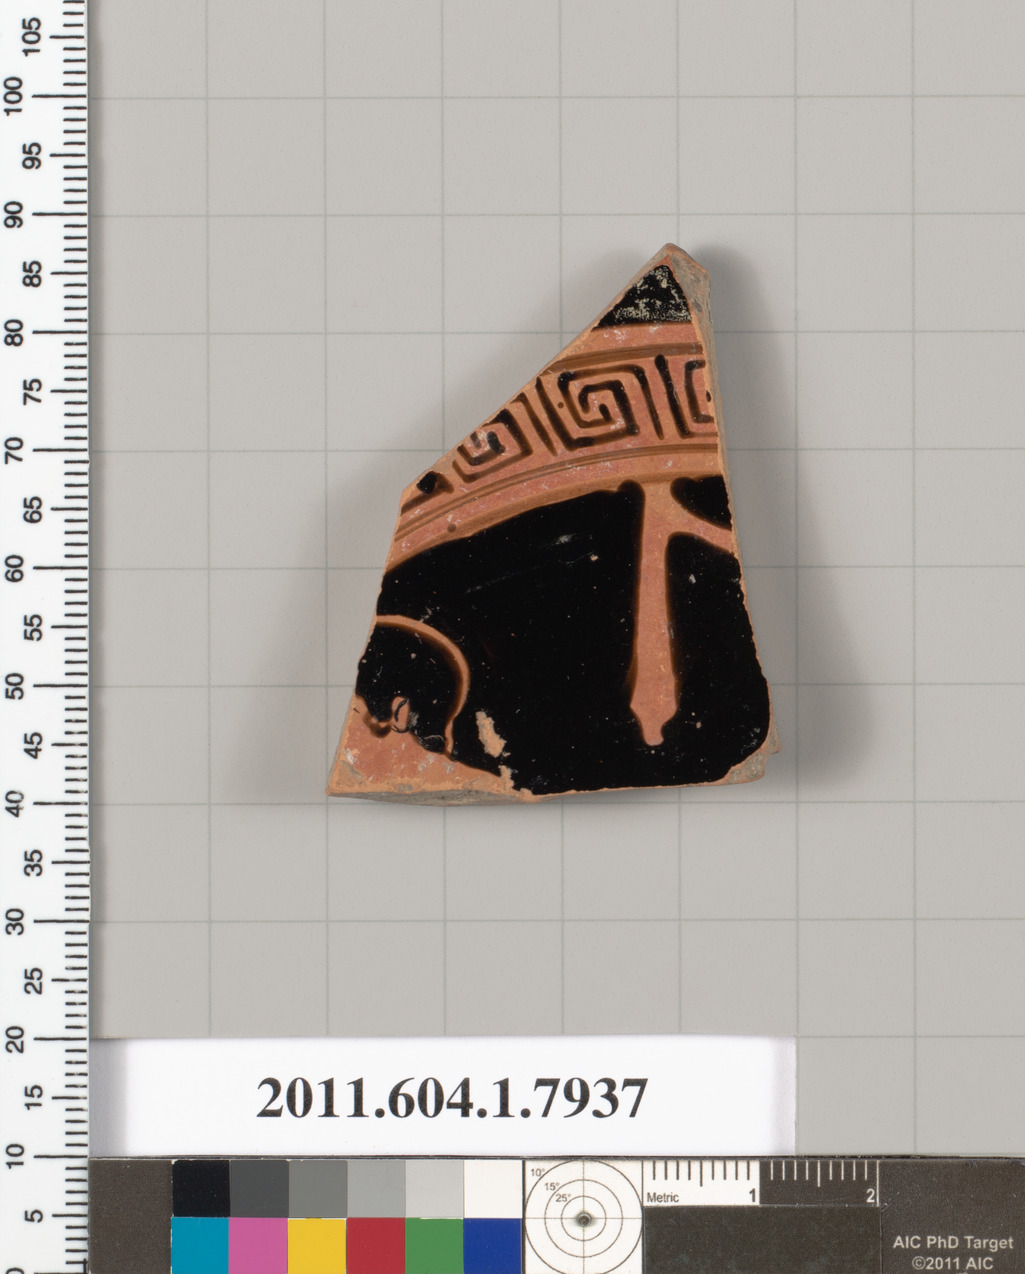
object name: kylix fragment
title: Terracotta fragment of a kylix (drinking cup)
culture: greek, attic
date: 460-450 BCE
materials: terracotta